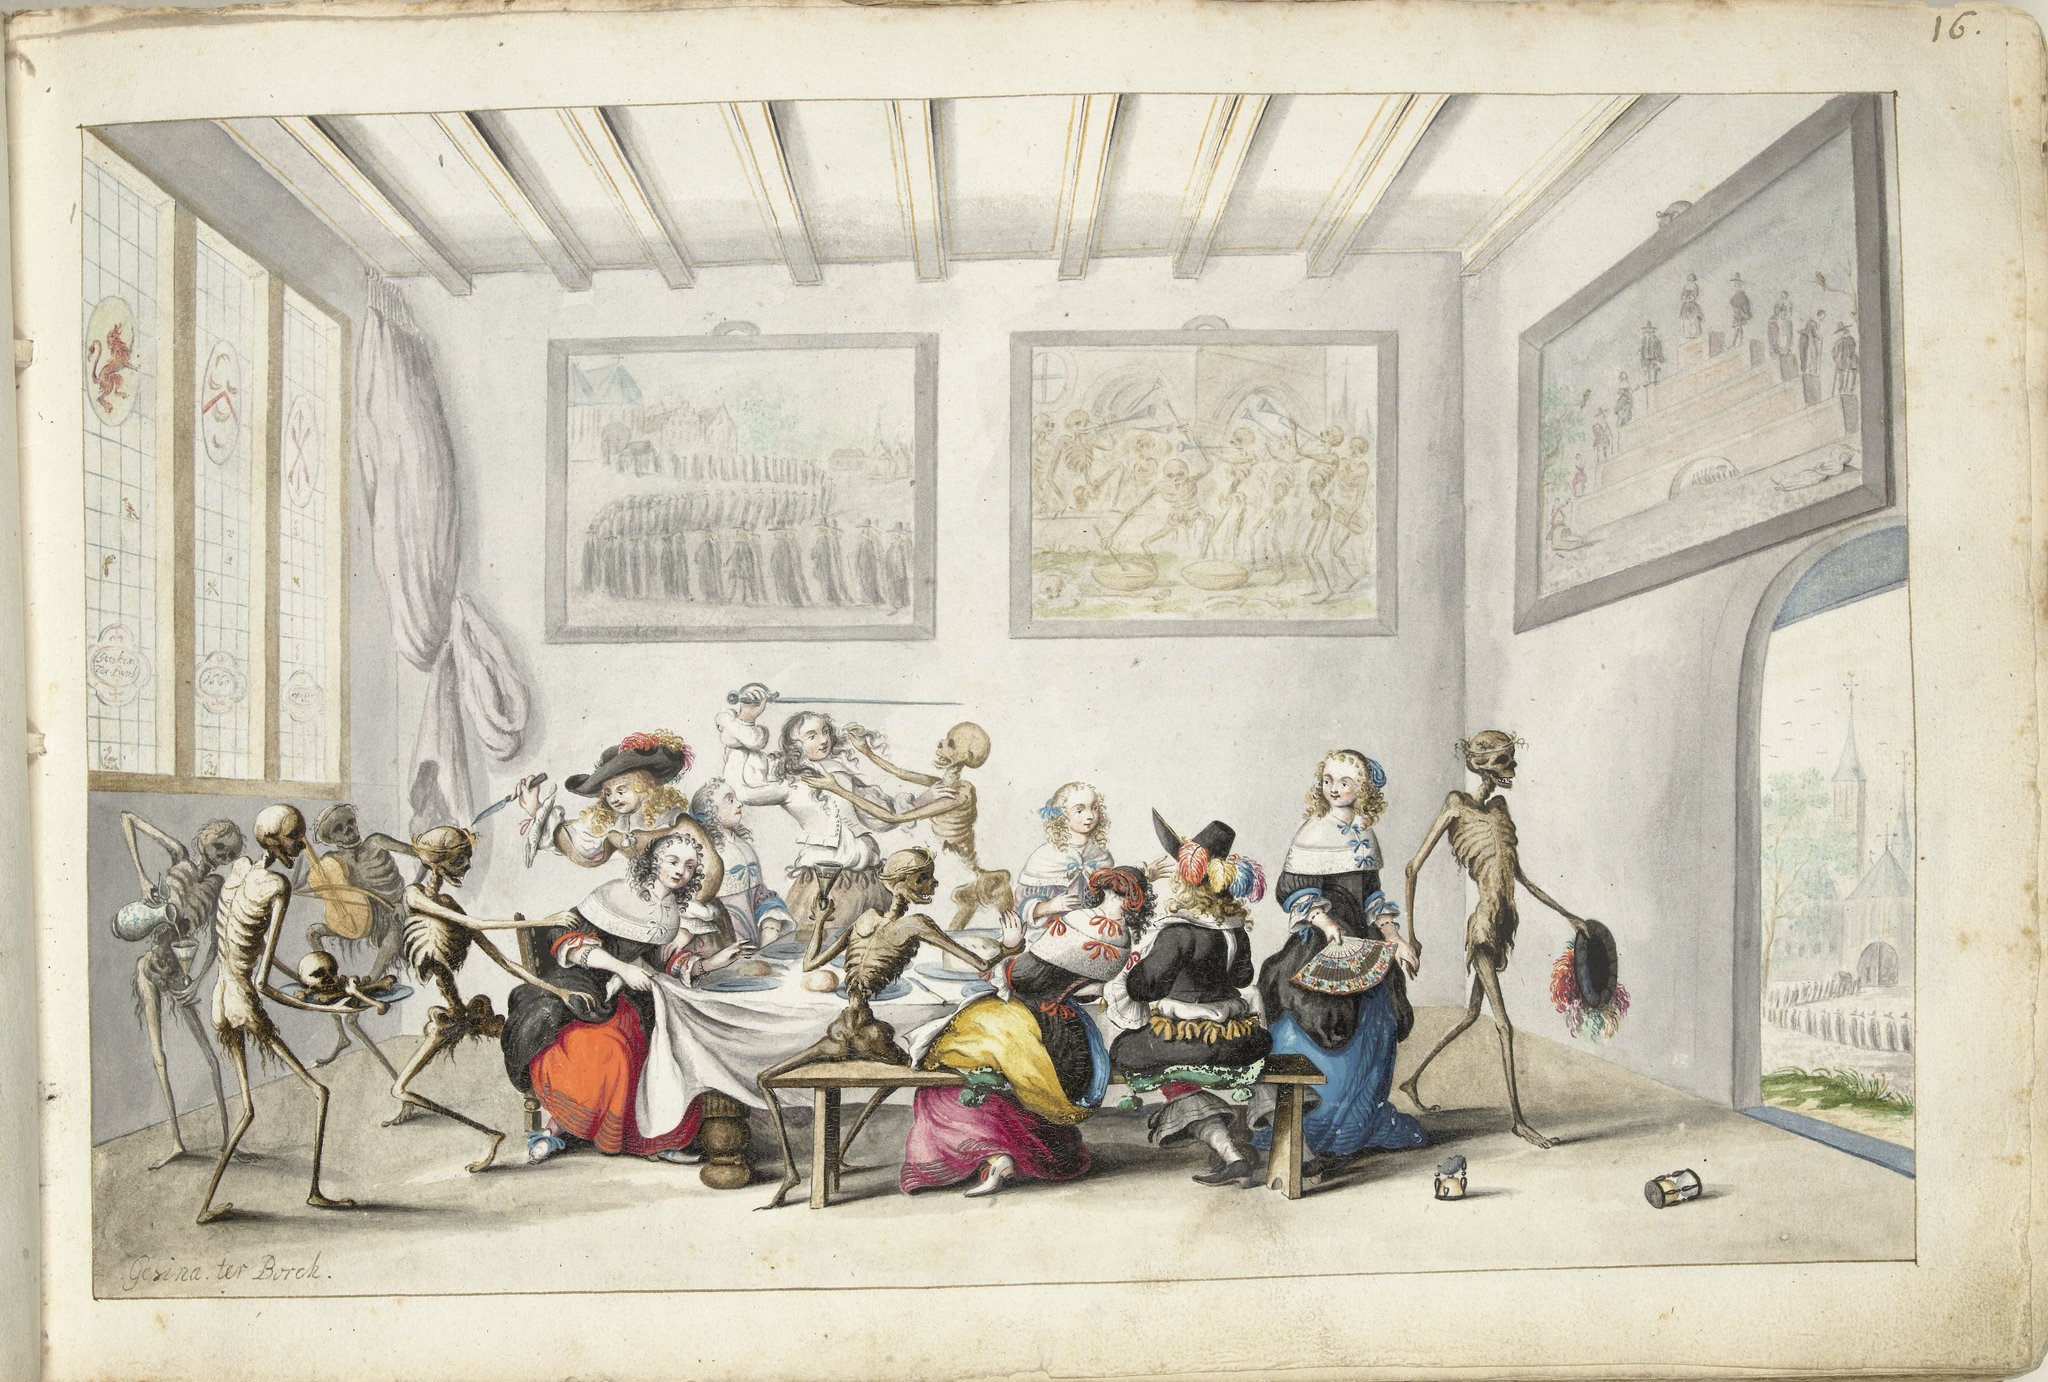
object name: drawing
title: Vrolijk gezelschap dat door de dood wordt gestoord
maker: gesina ter borch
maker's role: draughtsman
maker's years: 1633-1690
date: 1660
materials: chalk, ink, paper, watercolor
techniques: brush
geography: zwolle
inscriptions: signature and date: ‘Gesina ter Borch; Geesken Ter Borch, 1660, ... [onleesbaar]’